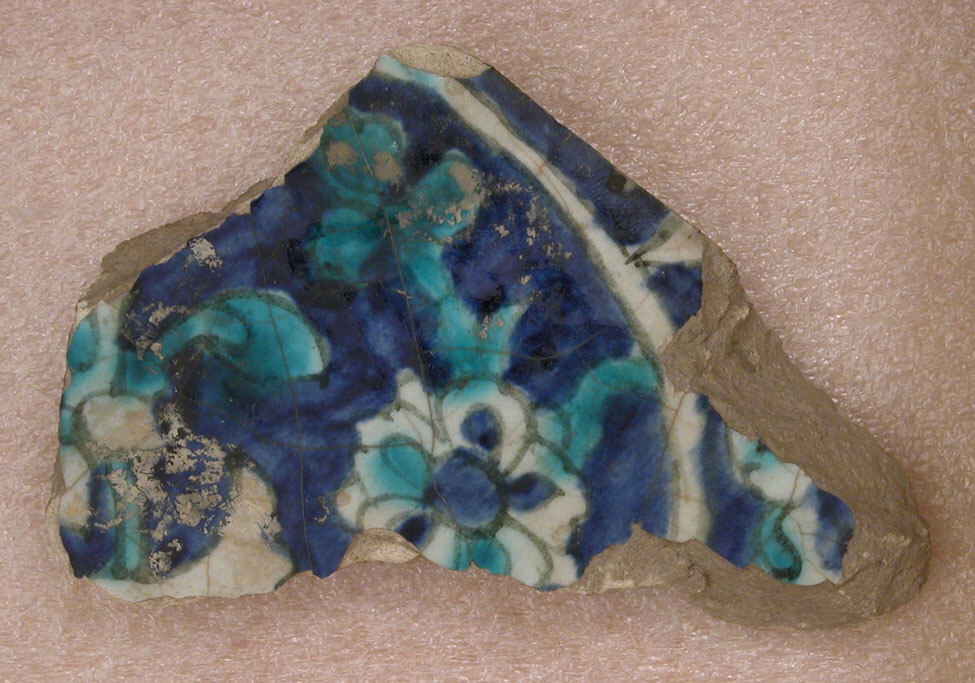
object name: tile fragment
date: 1334-1434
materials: glaze, stonepaste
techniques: painting, polychrome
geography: uzbekistan